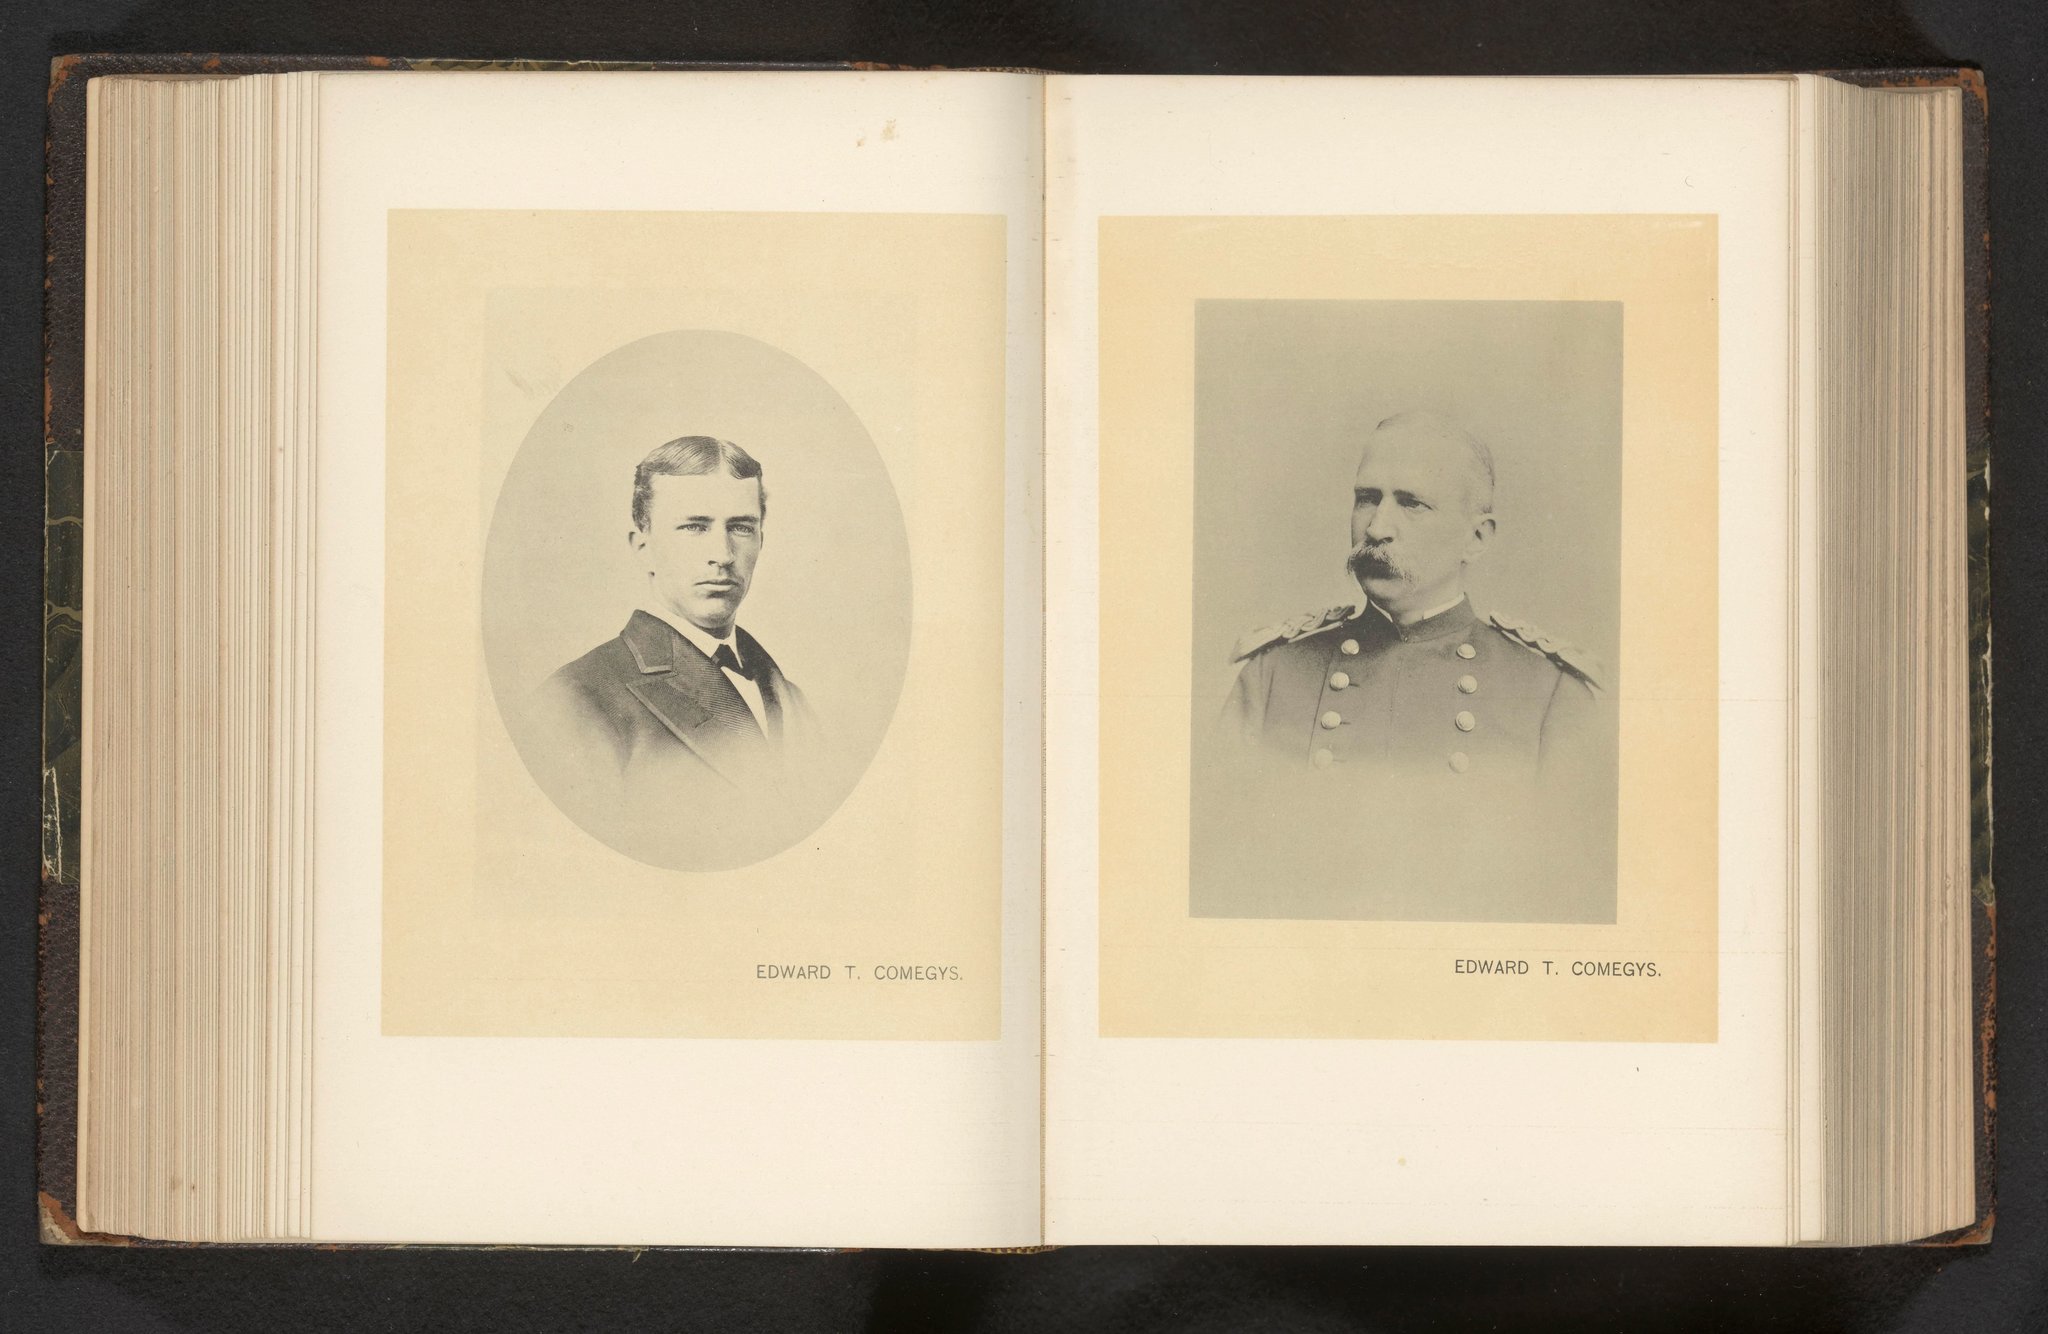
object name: photomechanical print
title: Edward T. Comegys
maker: Anonymous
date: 1889-1894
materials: paper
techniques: photoaquatint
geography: boston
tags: adult man